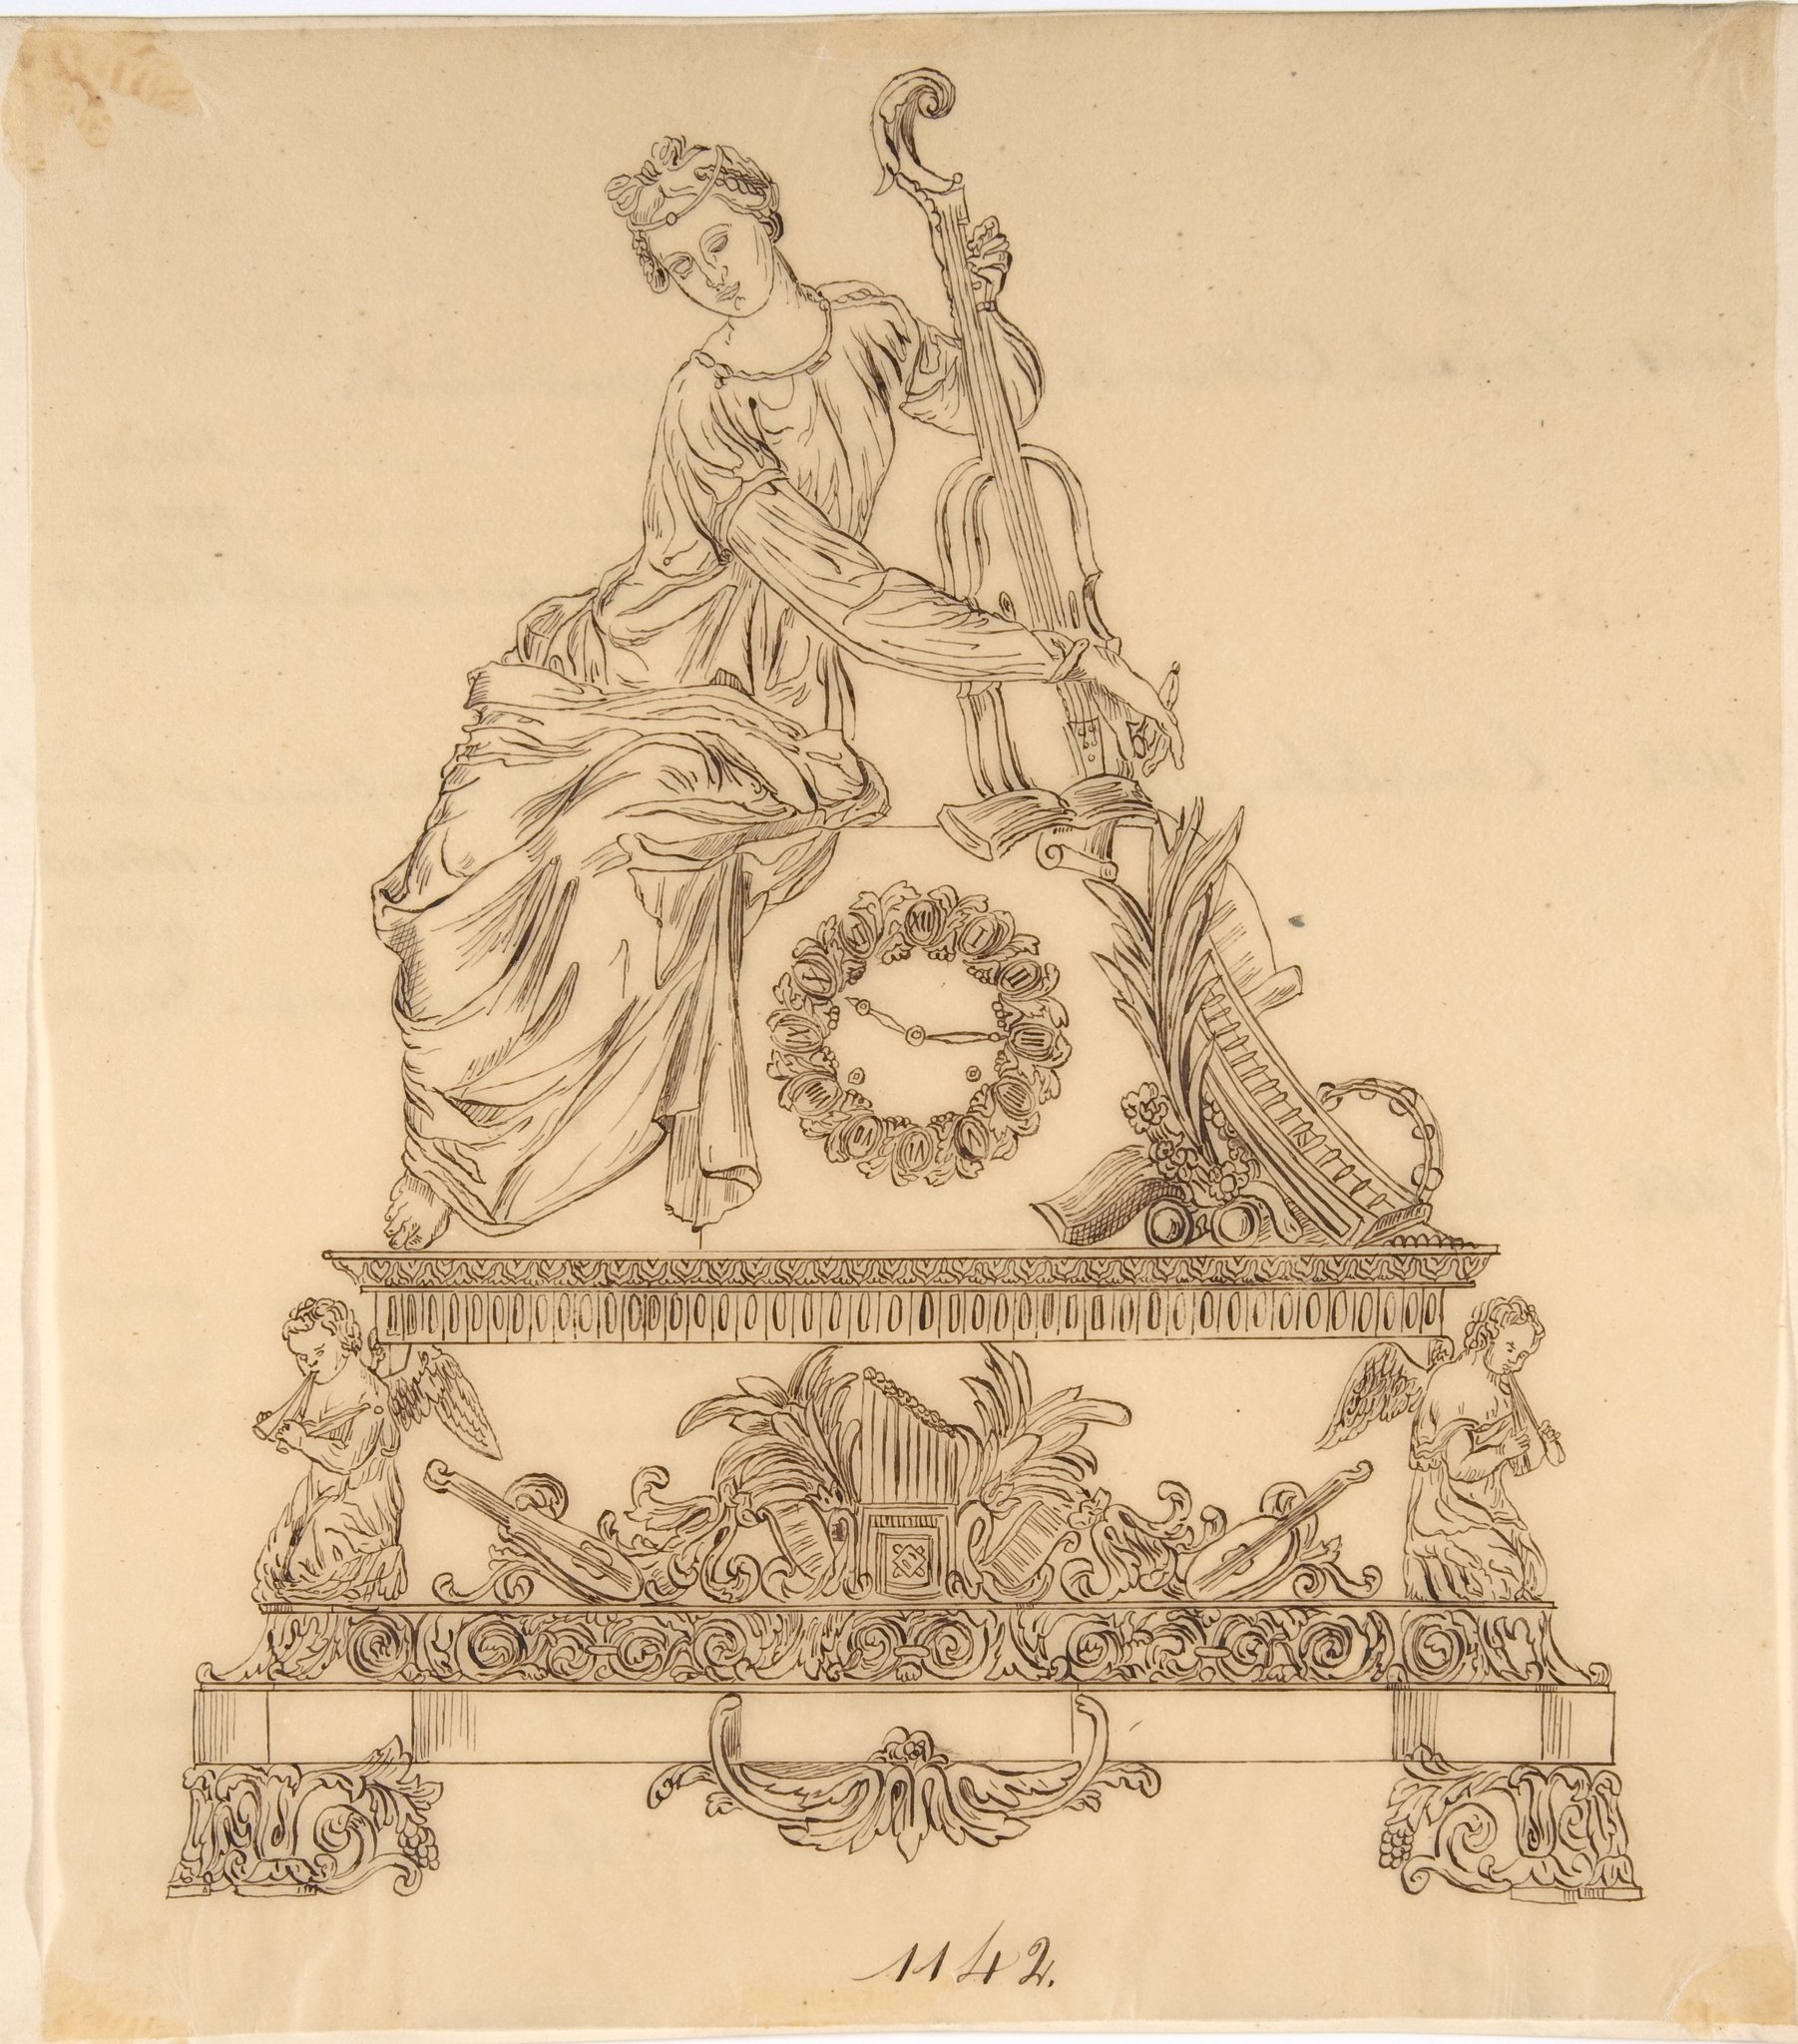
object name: drawing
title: Design for a Mantle Clock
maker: anonymous, french, 19th century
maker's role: artist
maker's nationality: french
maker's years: 1800-1900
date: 1801-1900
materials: ink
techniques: pen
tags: musical instruments,women,clocks